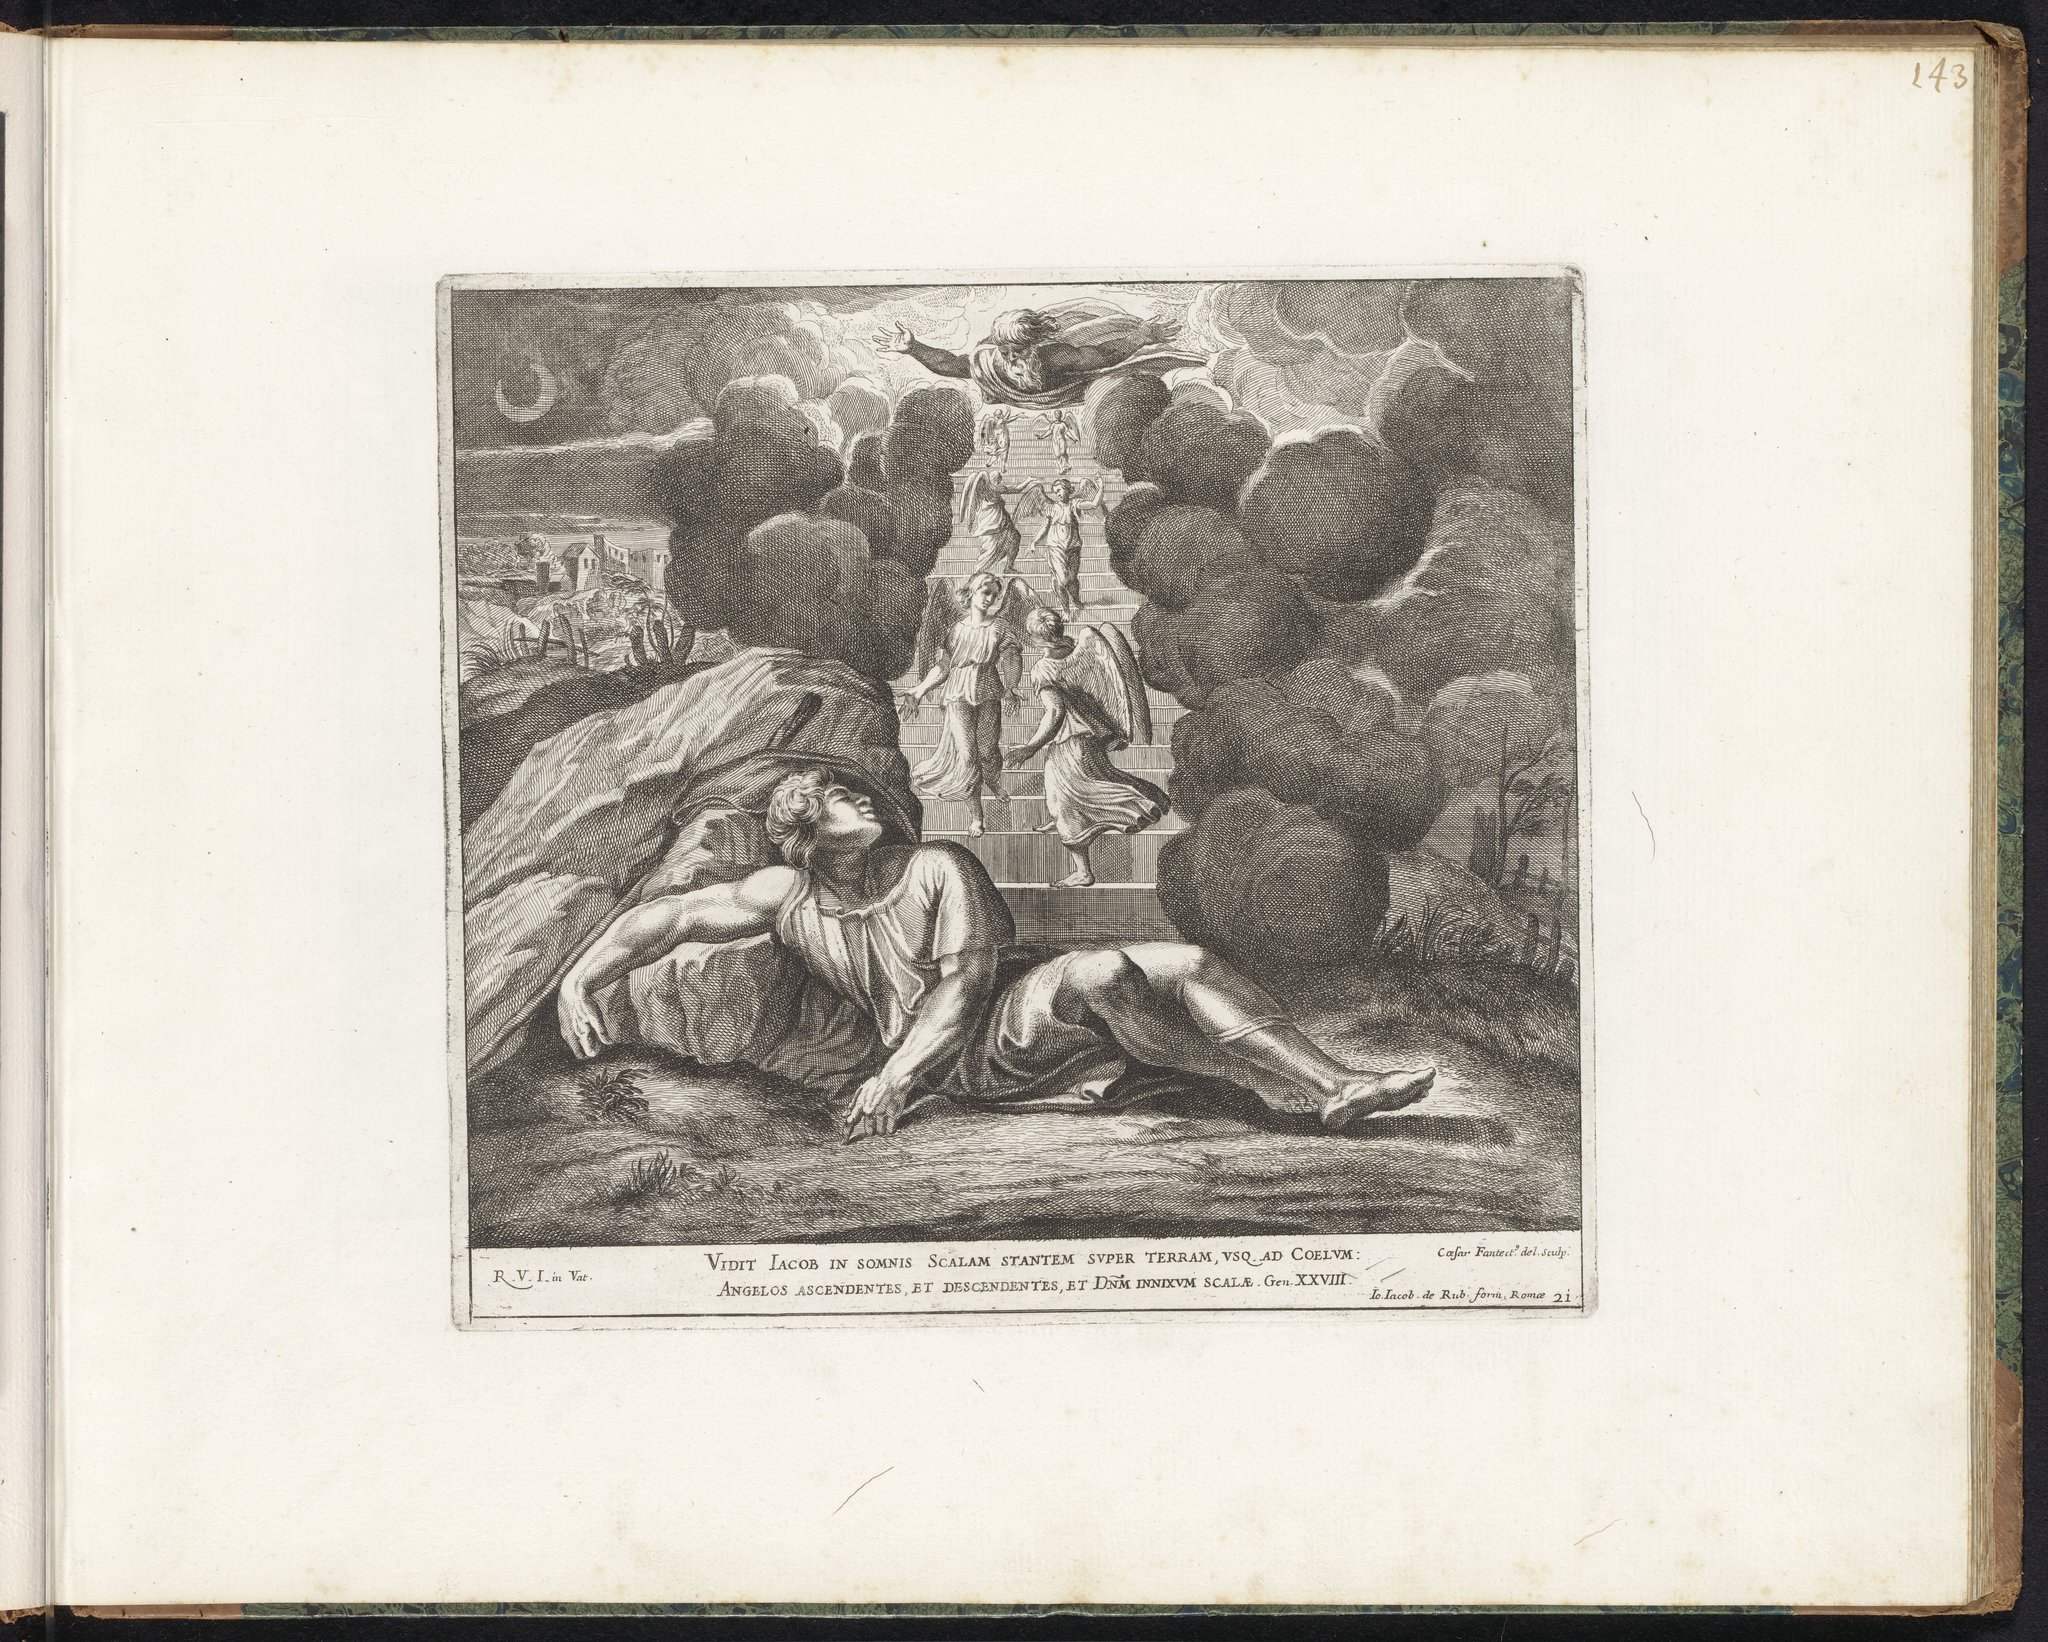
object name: album leaf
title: Rafaël Bijbel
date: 1675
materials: paper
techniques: etching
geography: italy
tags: the dream of jacob: while sleeping on the ground with a stone for pillow jacob sees a ladder reaching from earth to heaven with angels going up and down; usually with god at the top of the ladder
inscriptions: number: ‘143’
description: Jakob ligt te slapen, met zijn hoofd op een steen. Hij droomt over een ladder die tot aan de hemel reikt en waarlangs engelen afdalen. Bij de top van de ladder zweeft God de Vader. Bijbelvers onder de voorstelling. Prent maakt deel uit van een album.